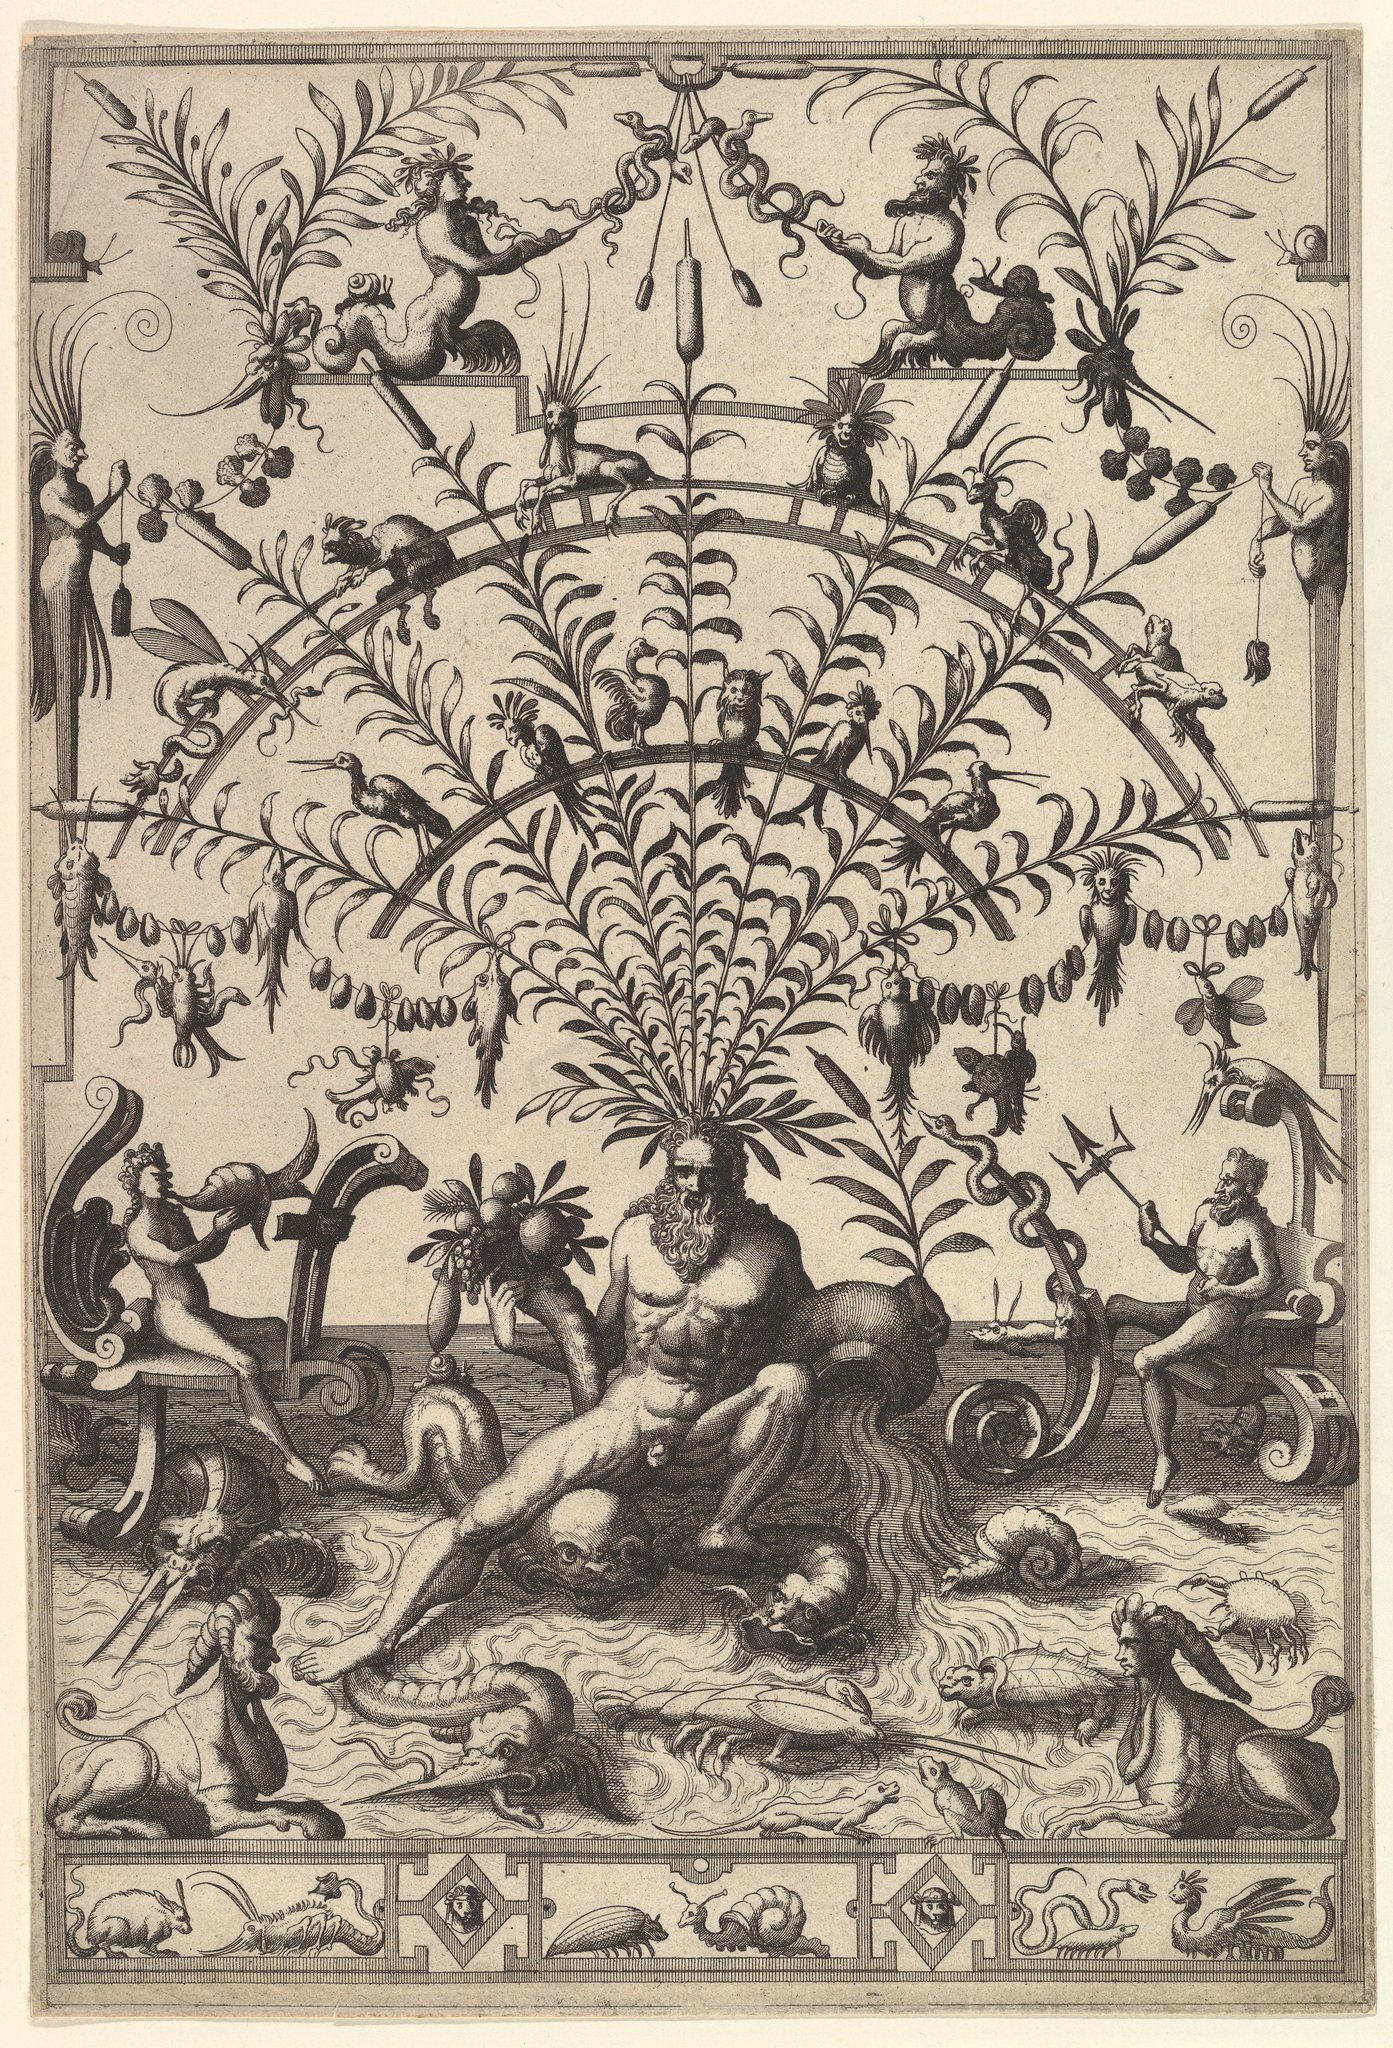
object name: print collection ornament architecture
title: Modern Grotesque Decoration with a River God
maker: johannes van doetecum i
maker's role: artist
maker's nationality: netherlandish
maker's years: 1528-1605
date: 1557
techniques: etching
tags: animals,male nudes,mythical creatures